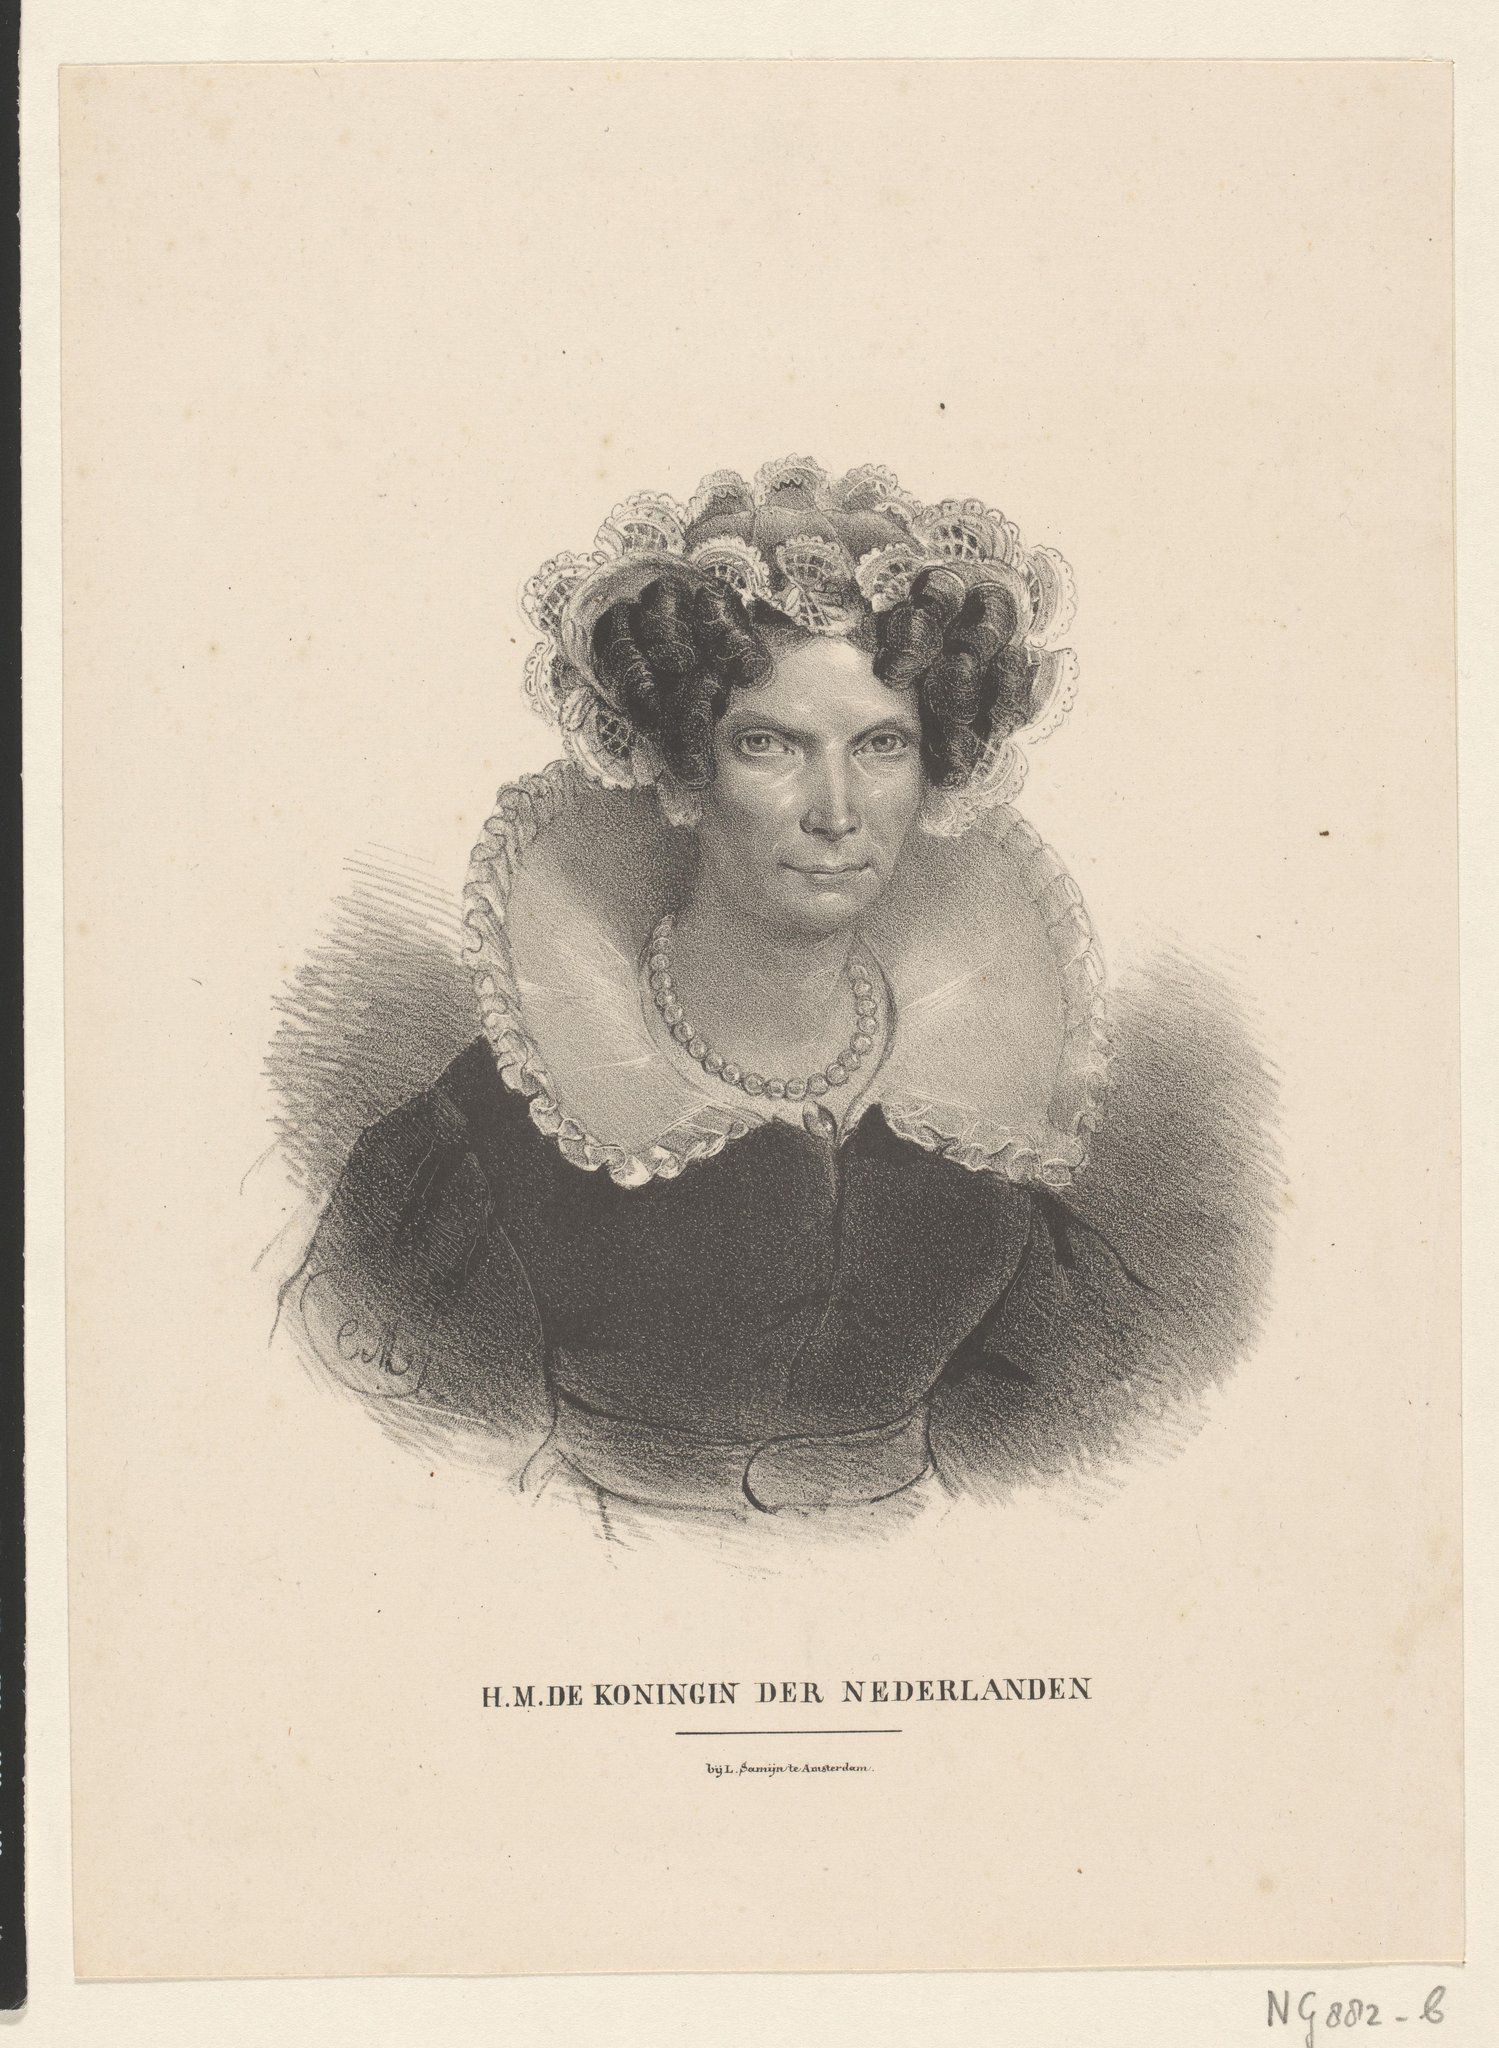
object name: print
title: H.M. de Koningin der Nederlanden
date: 1833-1836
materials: paper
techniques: lithograph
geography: amsterdam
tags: berlin, the hague, wilhelmina frederica louisa (koningin der nederlanden)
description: Portret van koningin Wilhelmina Frederica Louisa, koningin der Nederlanden. Echtgenote van koning Willem I. Buste naar rechts.